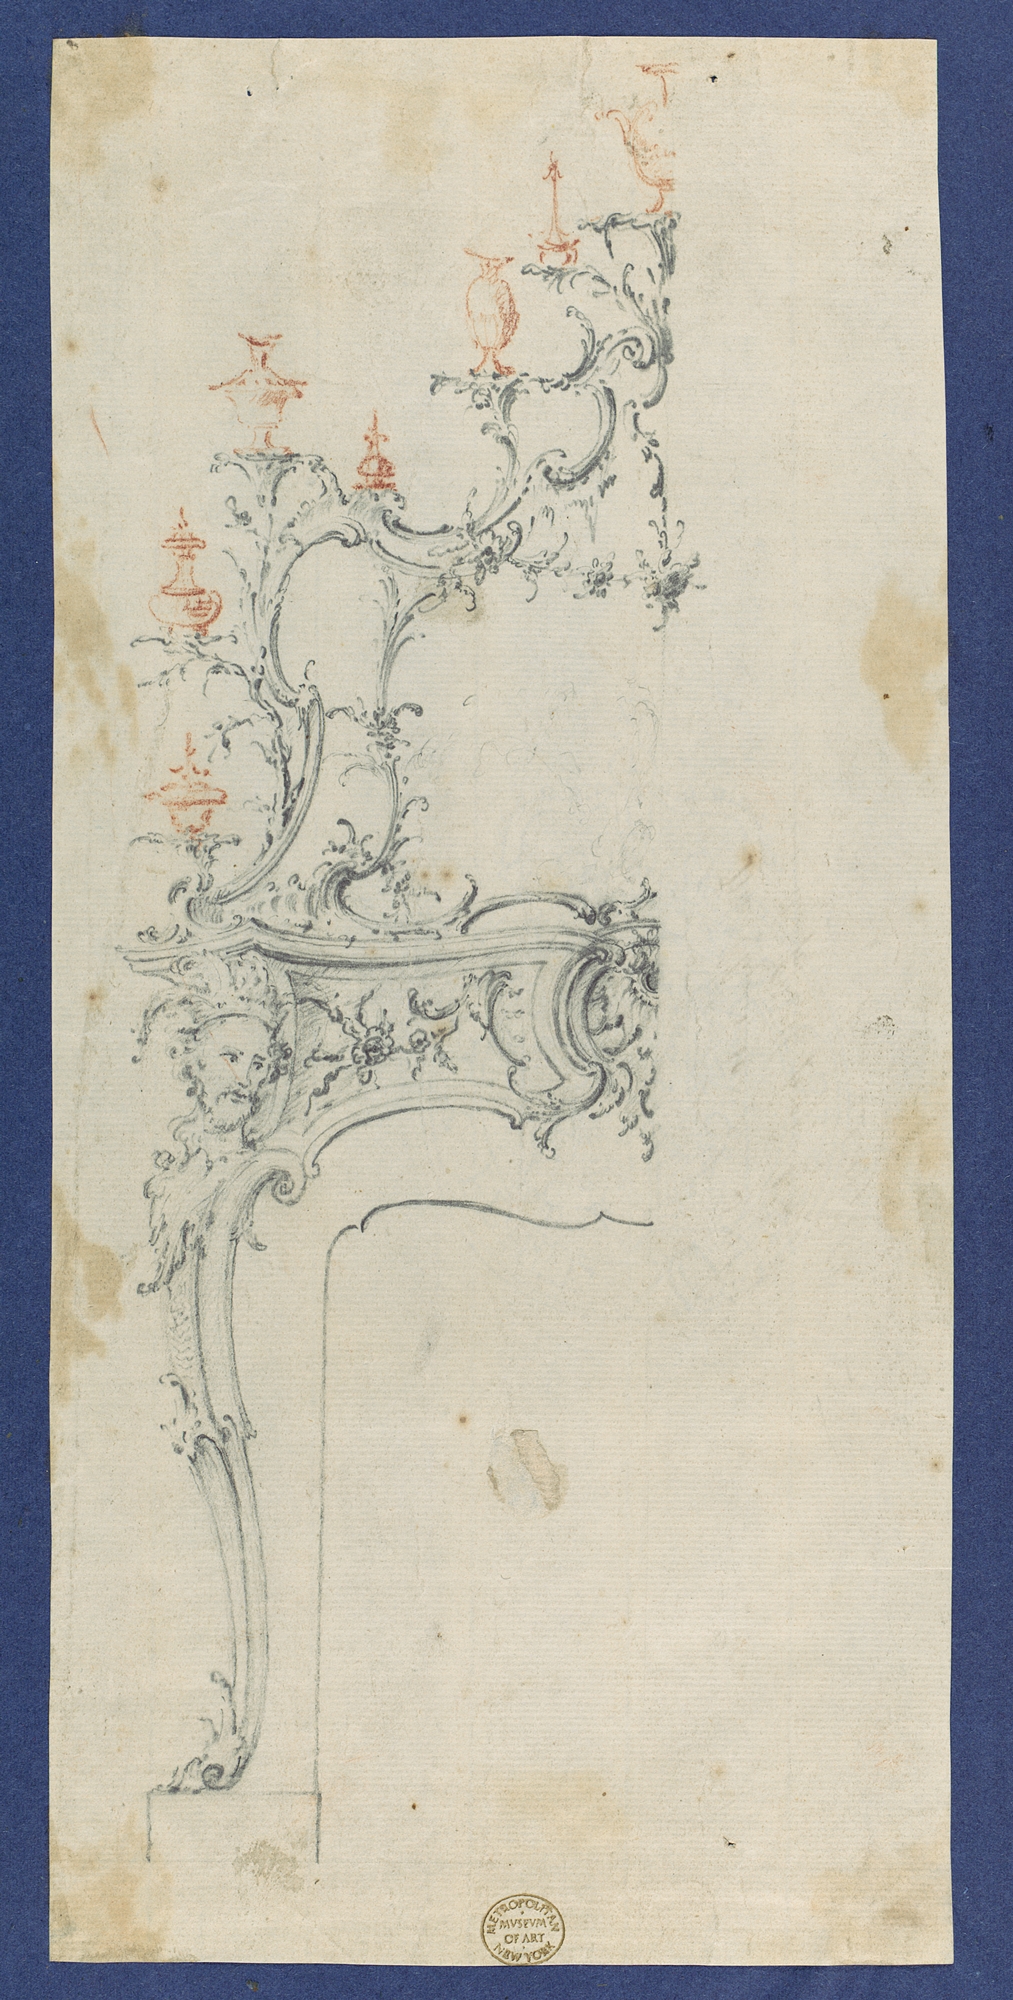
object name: drawing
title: Chimneypiece, in Chippendale Drawings, Vol. I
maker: thomas chippendale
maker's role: artist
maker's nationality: british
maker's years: 1718-1779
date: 1753-1762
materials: chalk, graphite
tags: ornament